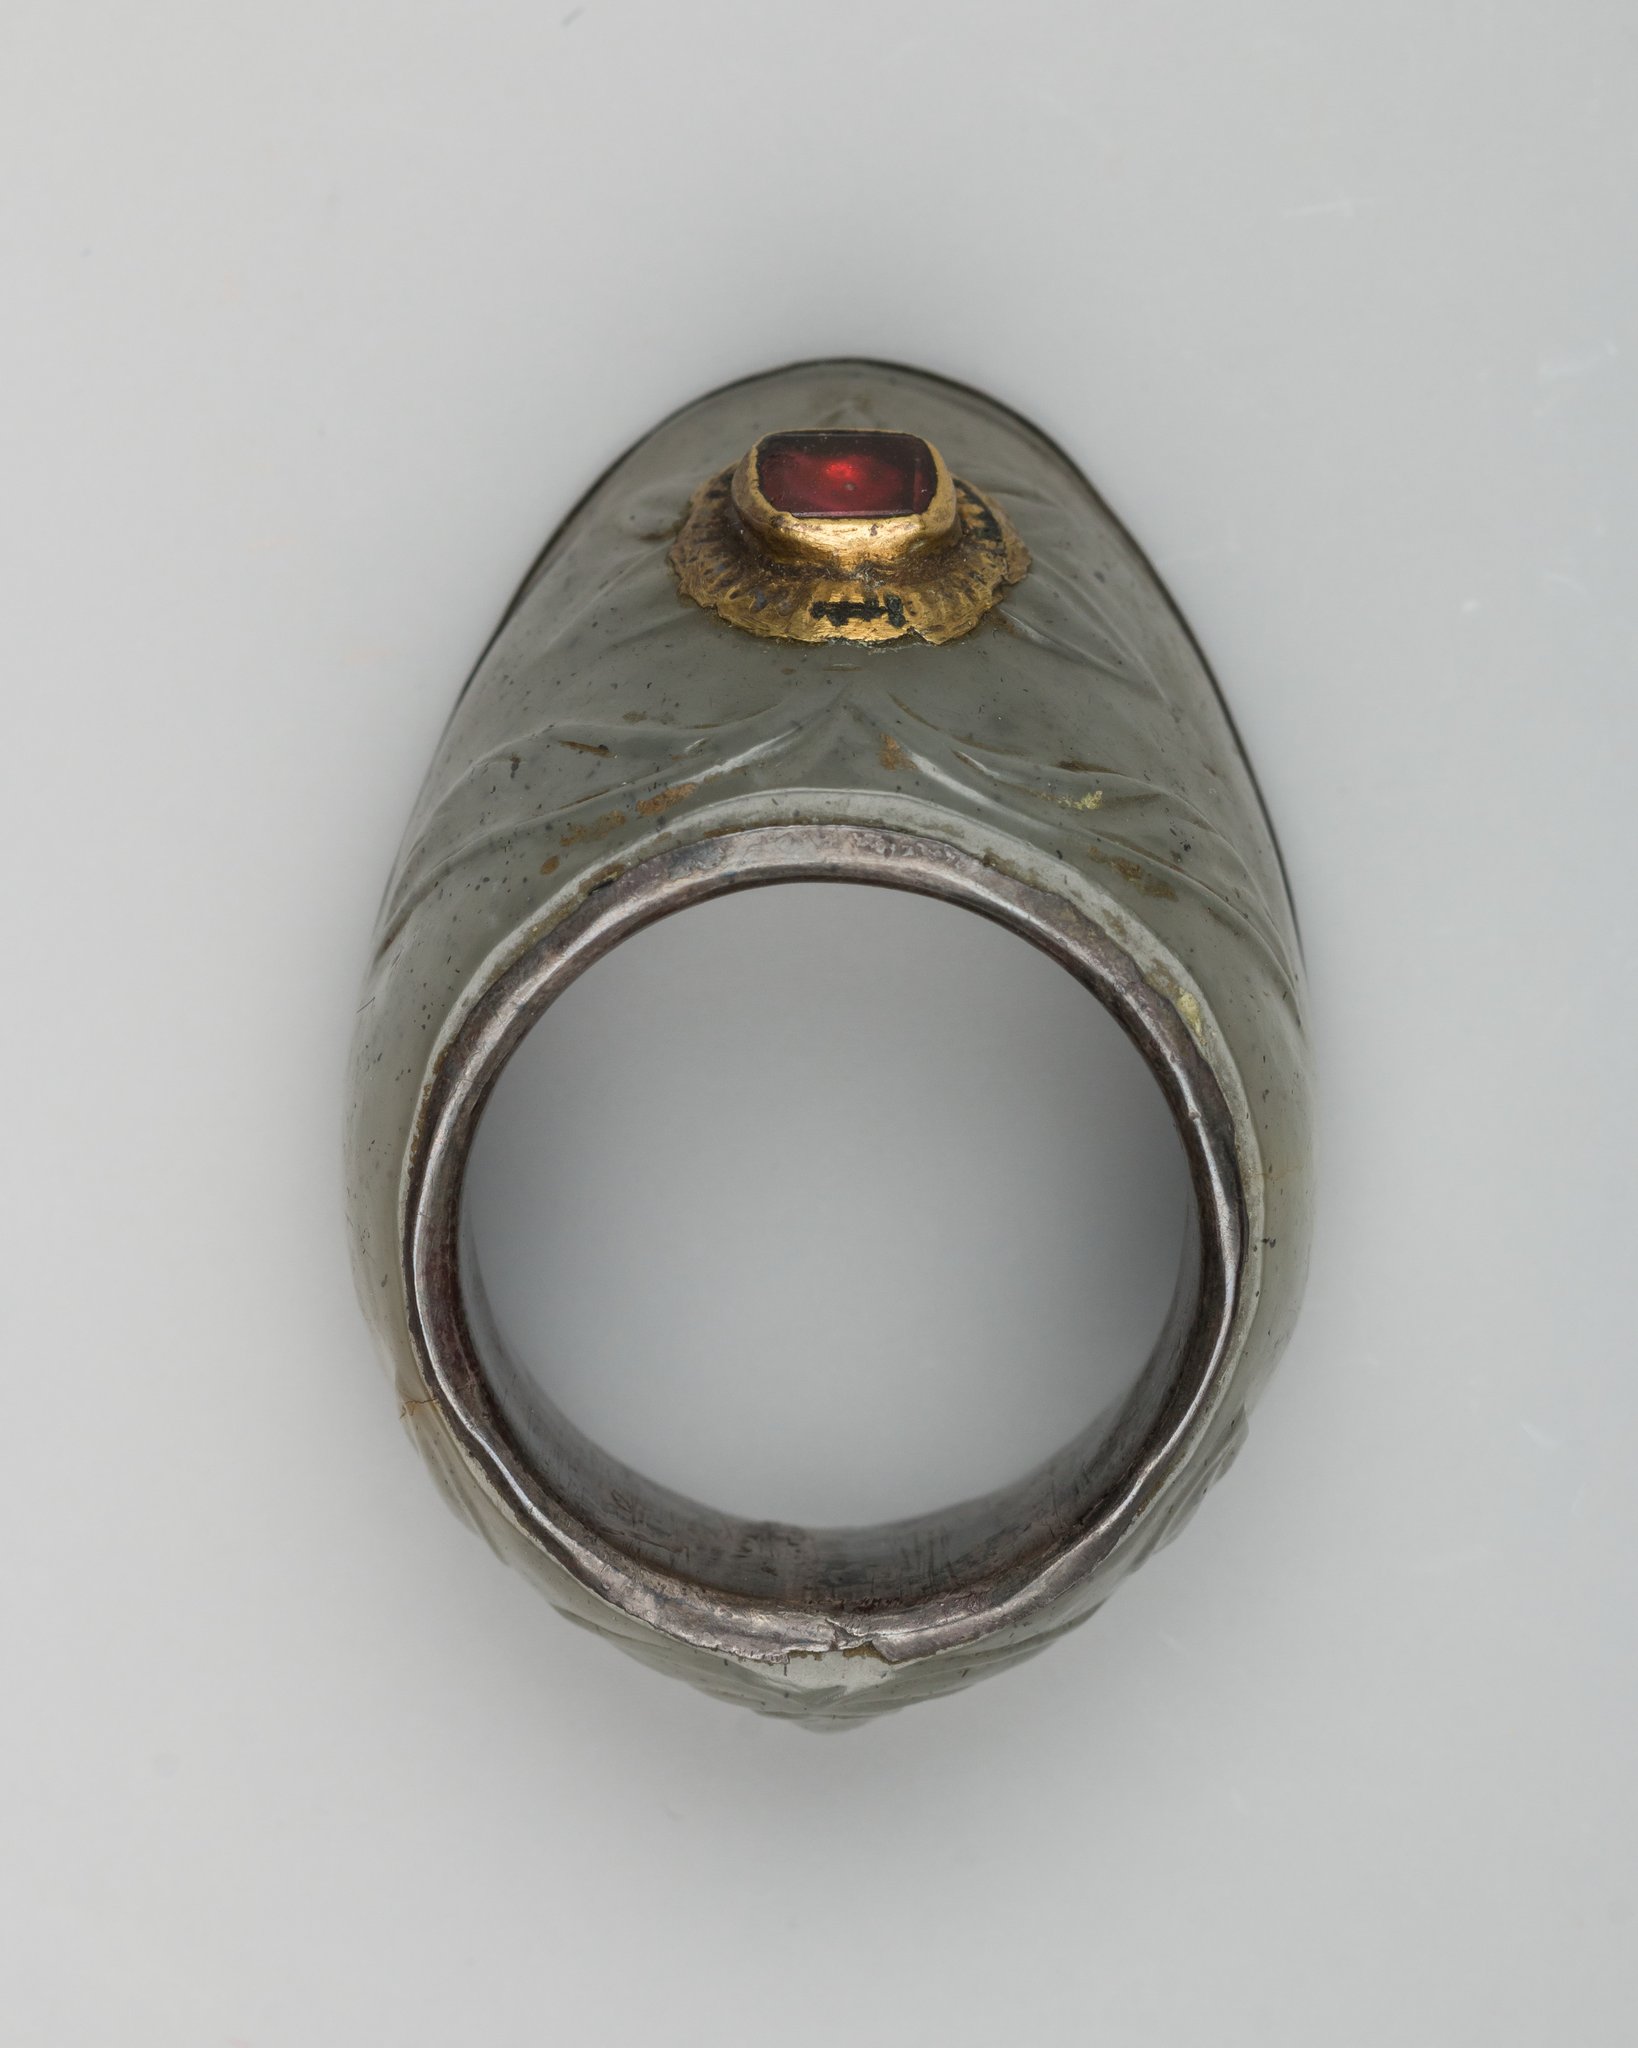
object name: archer's ring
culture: turkish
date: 1701-1800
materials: gold, jade, silver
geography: ottoman empire